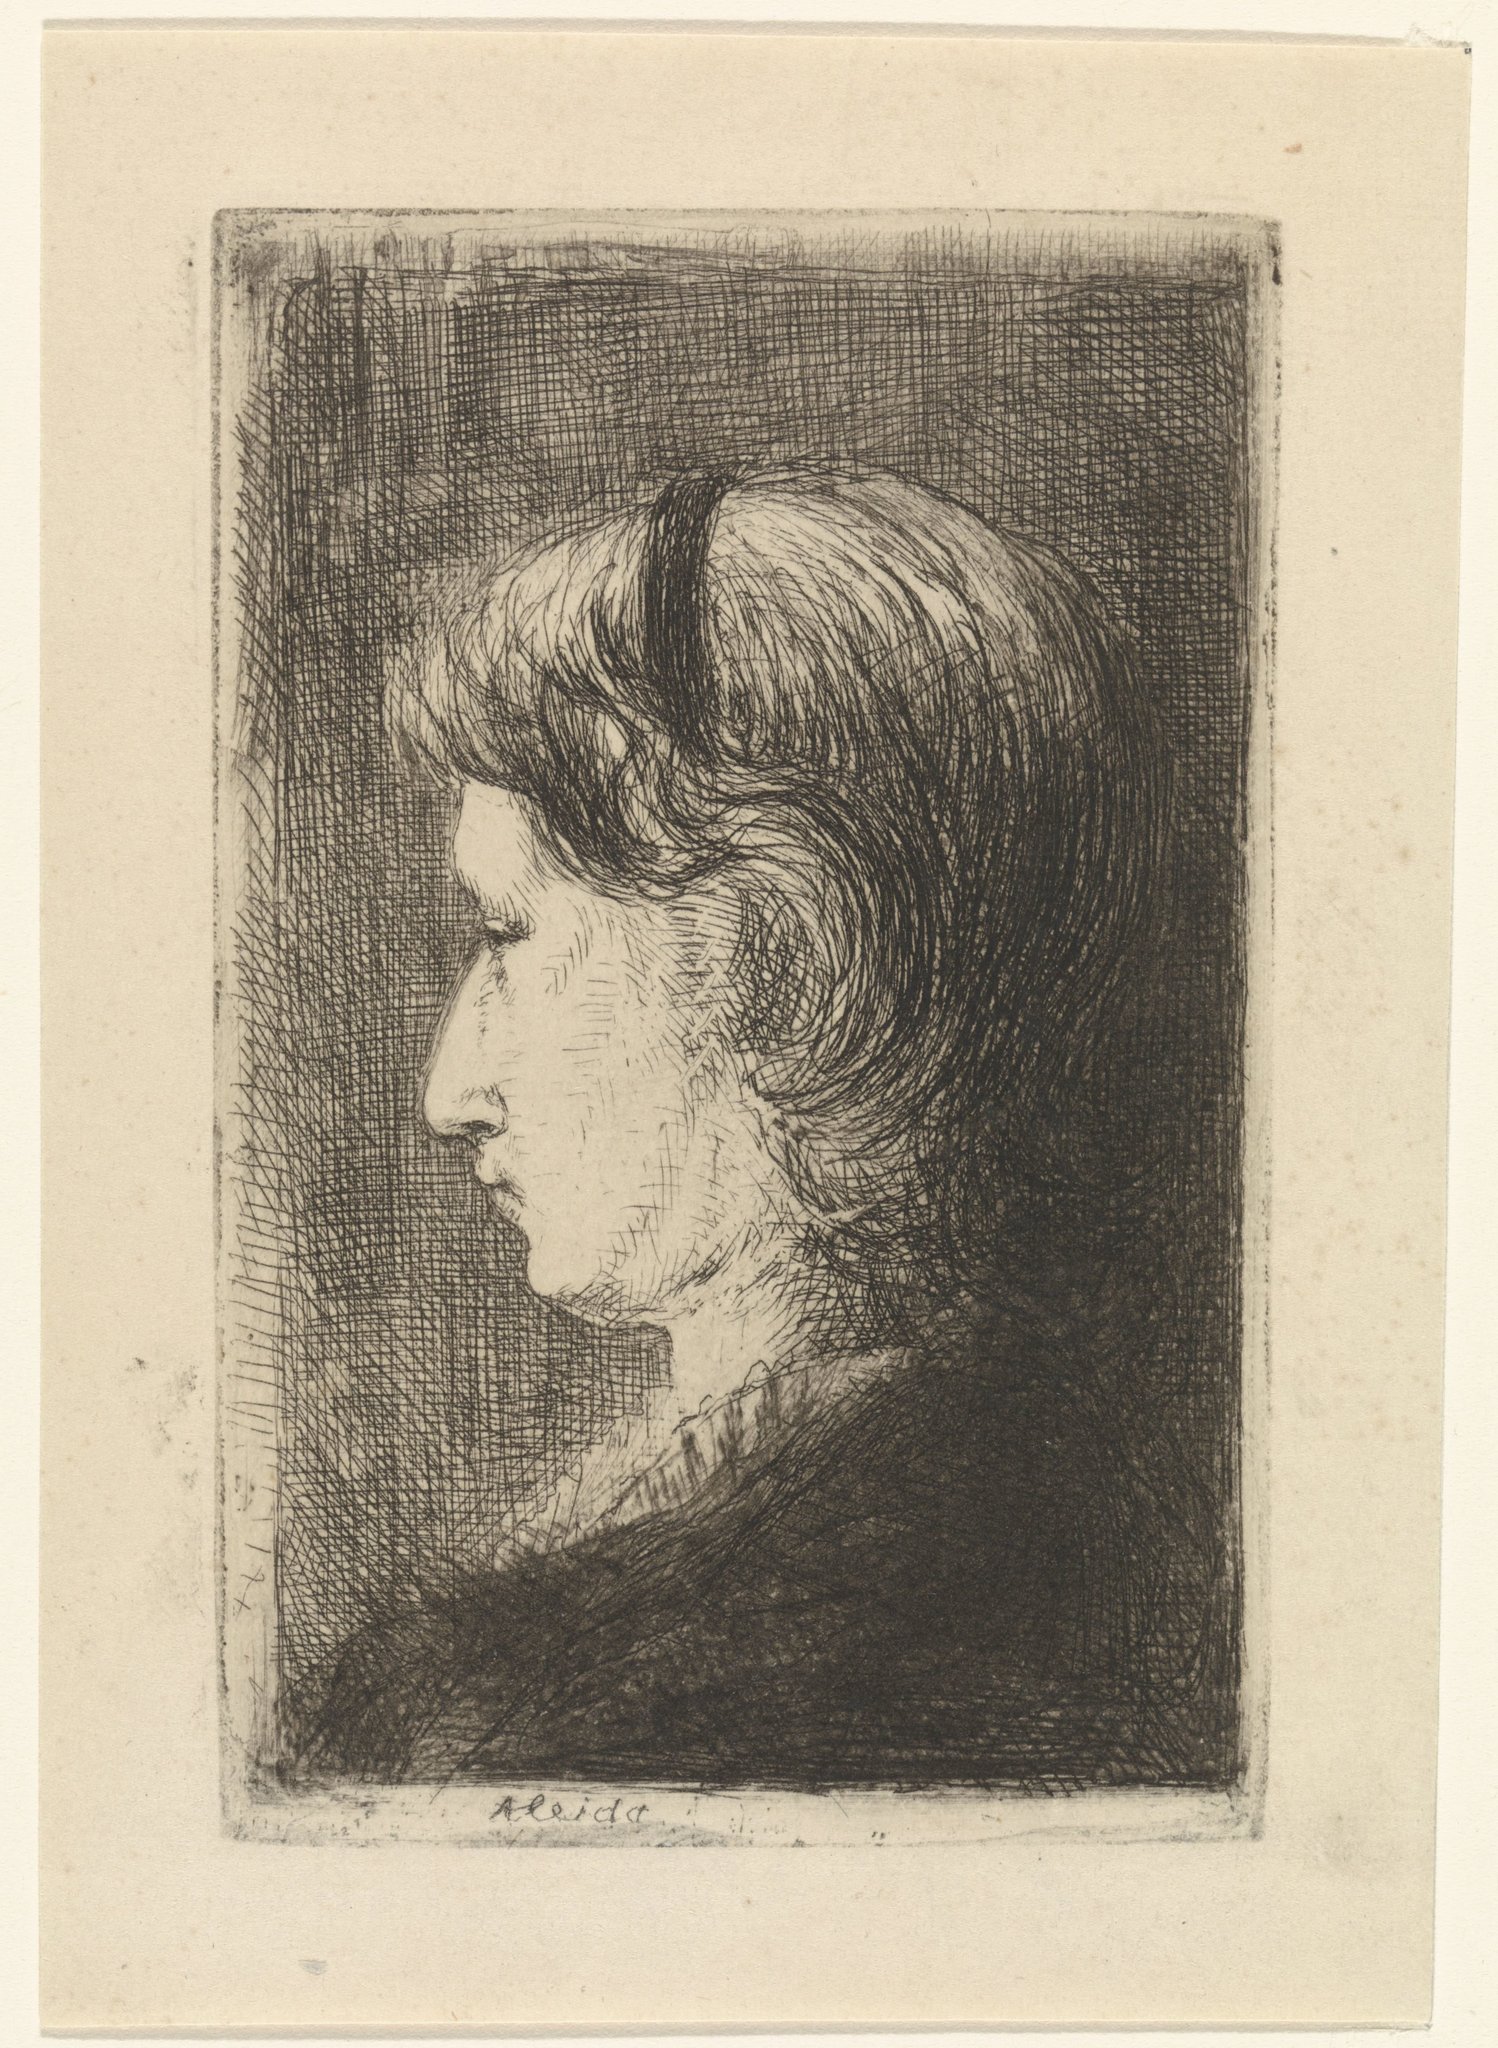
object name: print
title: Portret van Aleida Schaap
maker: jozef israëls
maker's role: draughtsman, painter, print maker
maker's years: 1824-1911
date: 1863-1878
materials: paper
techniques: etching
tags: aleida schaap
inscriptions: collector's mark: Lugt 2228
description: Portret van Aleida Schaap, vrouw van kunstenaar Jozef Israëls, met haarband. Links onder de voorstelling: "Aleida".